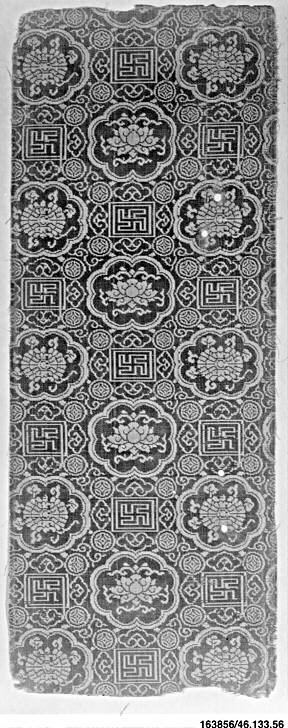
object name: sutra cover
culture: chinese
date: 1601-1800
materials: silk